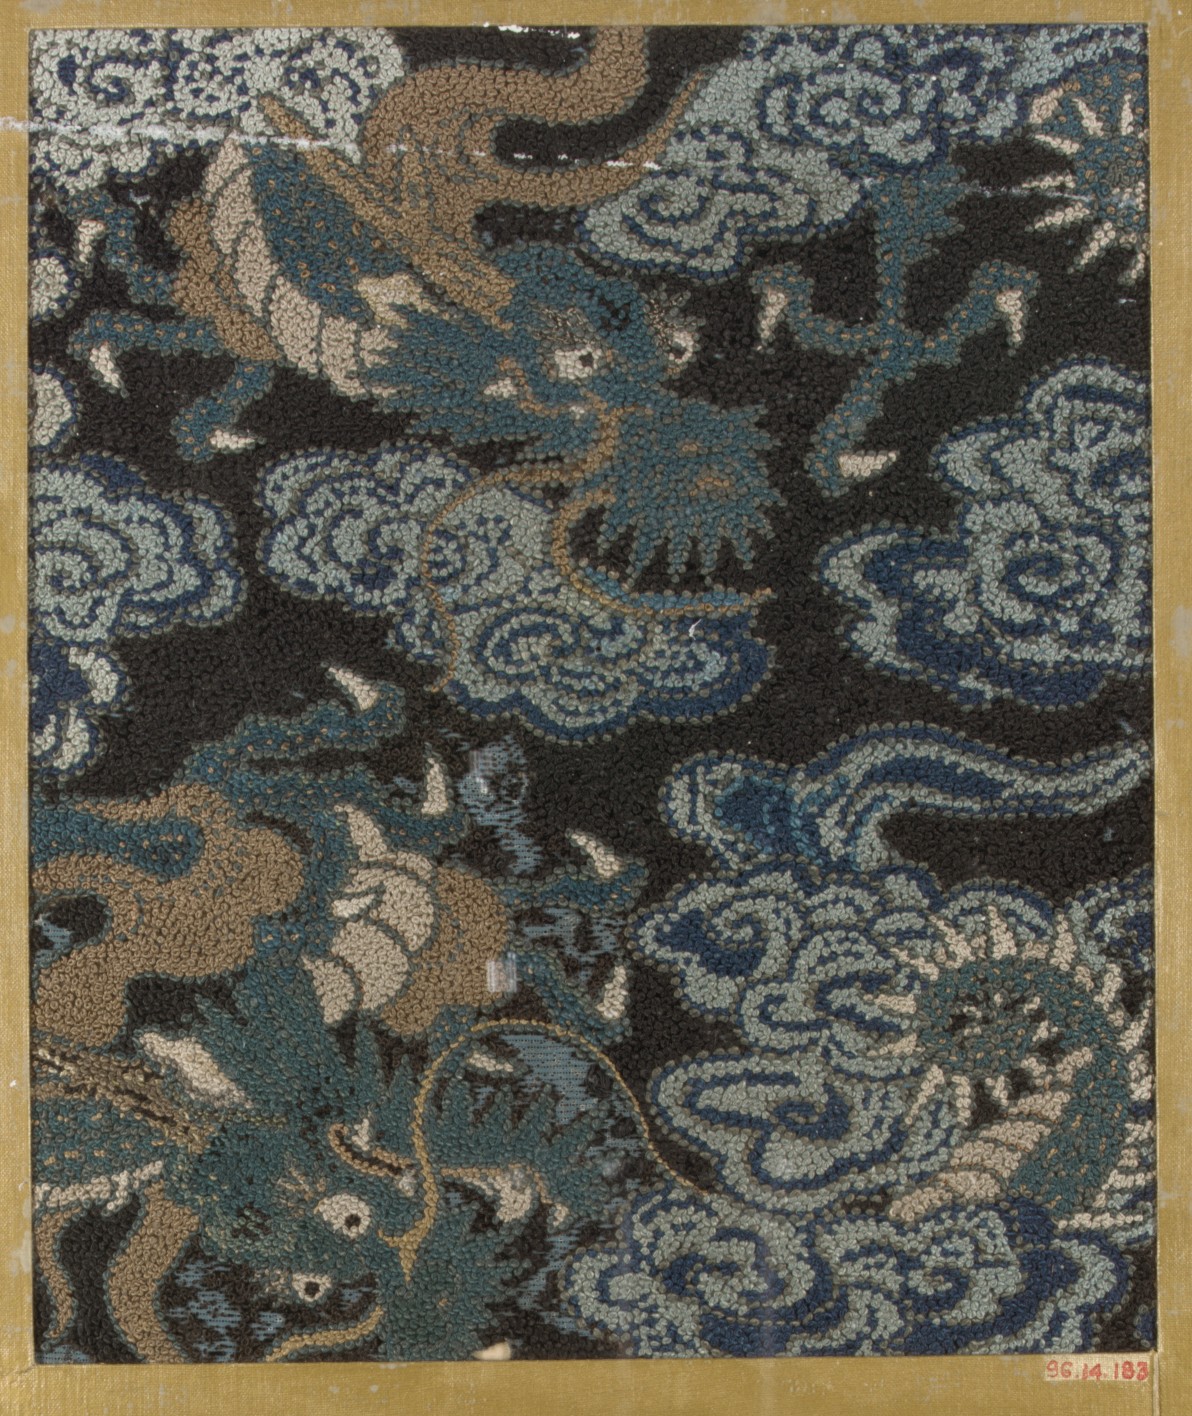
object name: fragment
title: Textile fragment with pattern of three-clawed dragons in clouds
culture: japanese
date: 1701-1900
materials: silk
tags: dragons